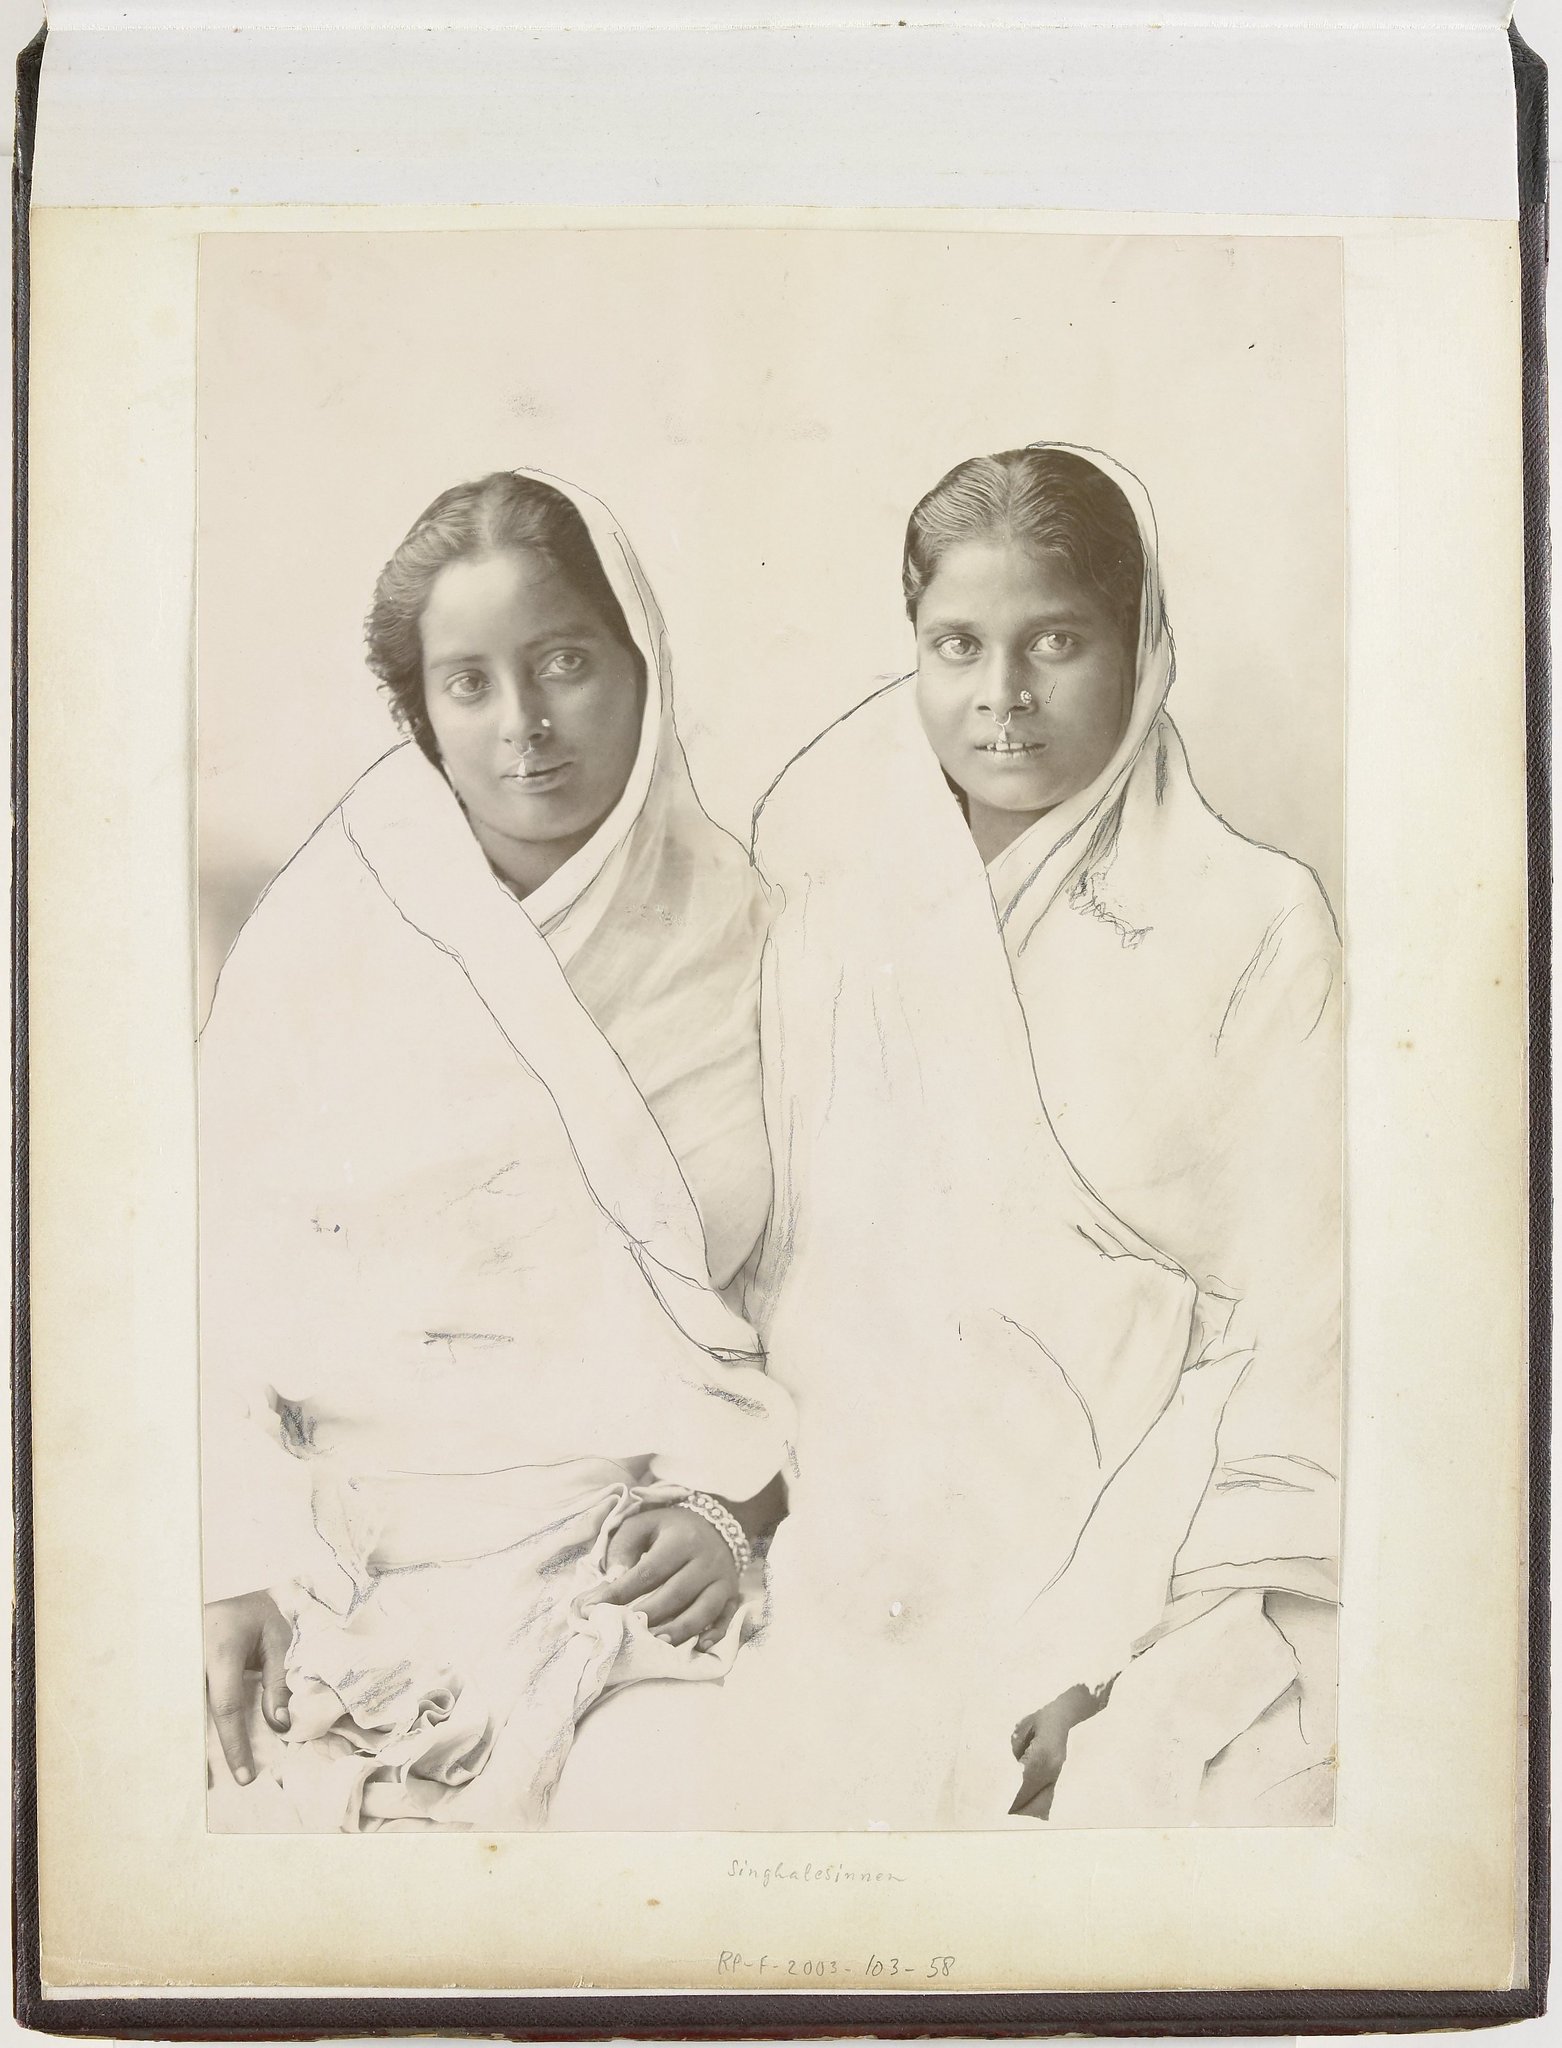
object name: photograph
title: Two young Sinhala women, Sri Lanka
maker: Anonymous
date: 1890-1900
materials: cardboard, paper, photographic support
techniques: albumen print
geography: sri lanka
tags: sumatra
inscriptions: caption: ‘Singhalesinnen’